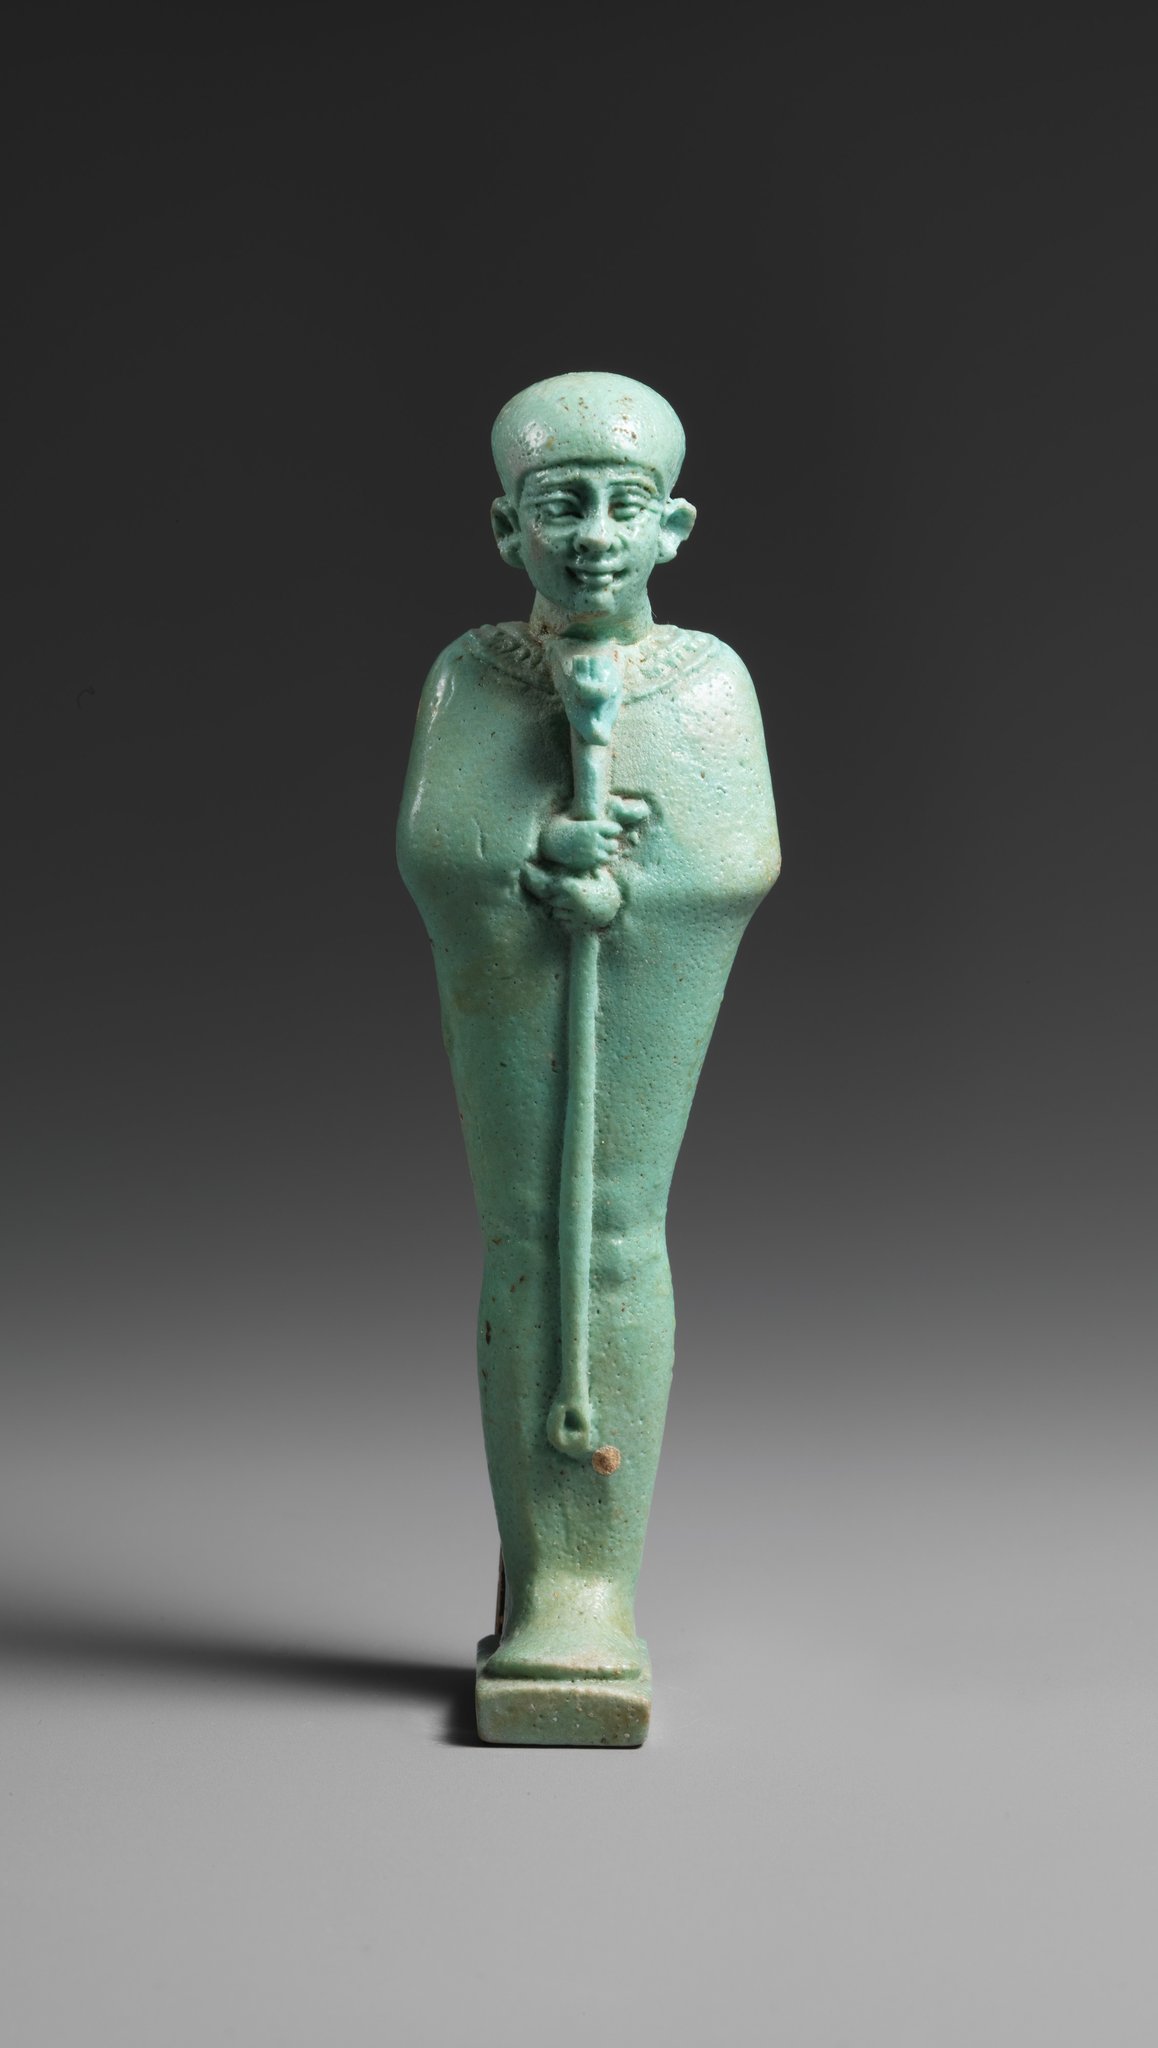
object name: statuette, ptah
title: Standing Figure of Ptah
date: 664-332 BCE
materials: faience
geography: egypt